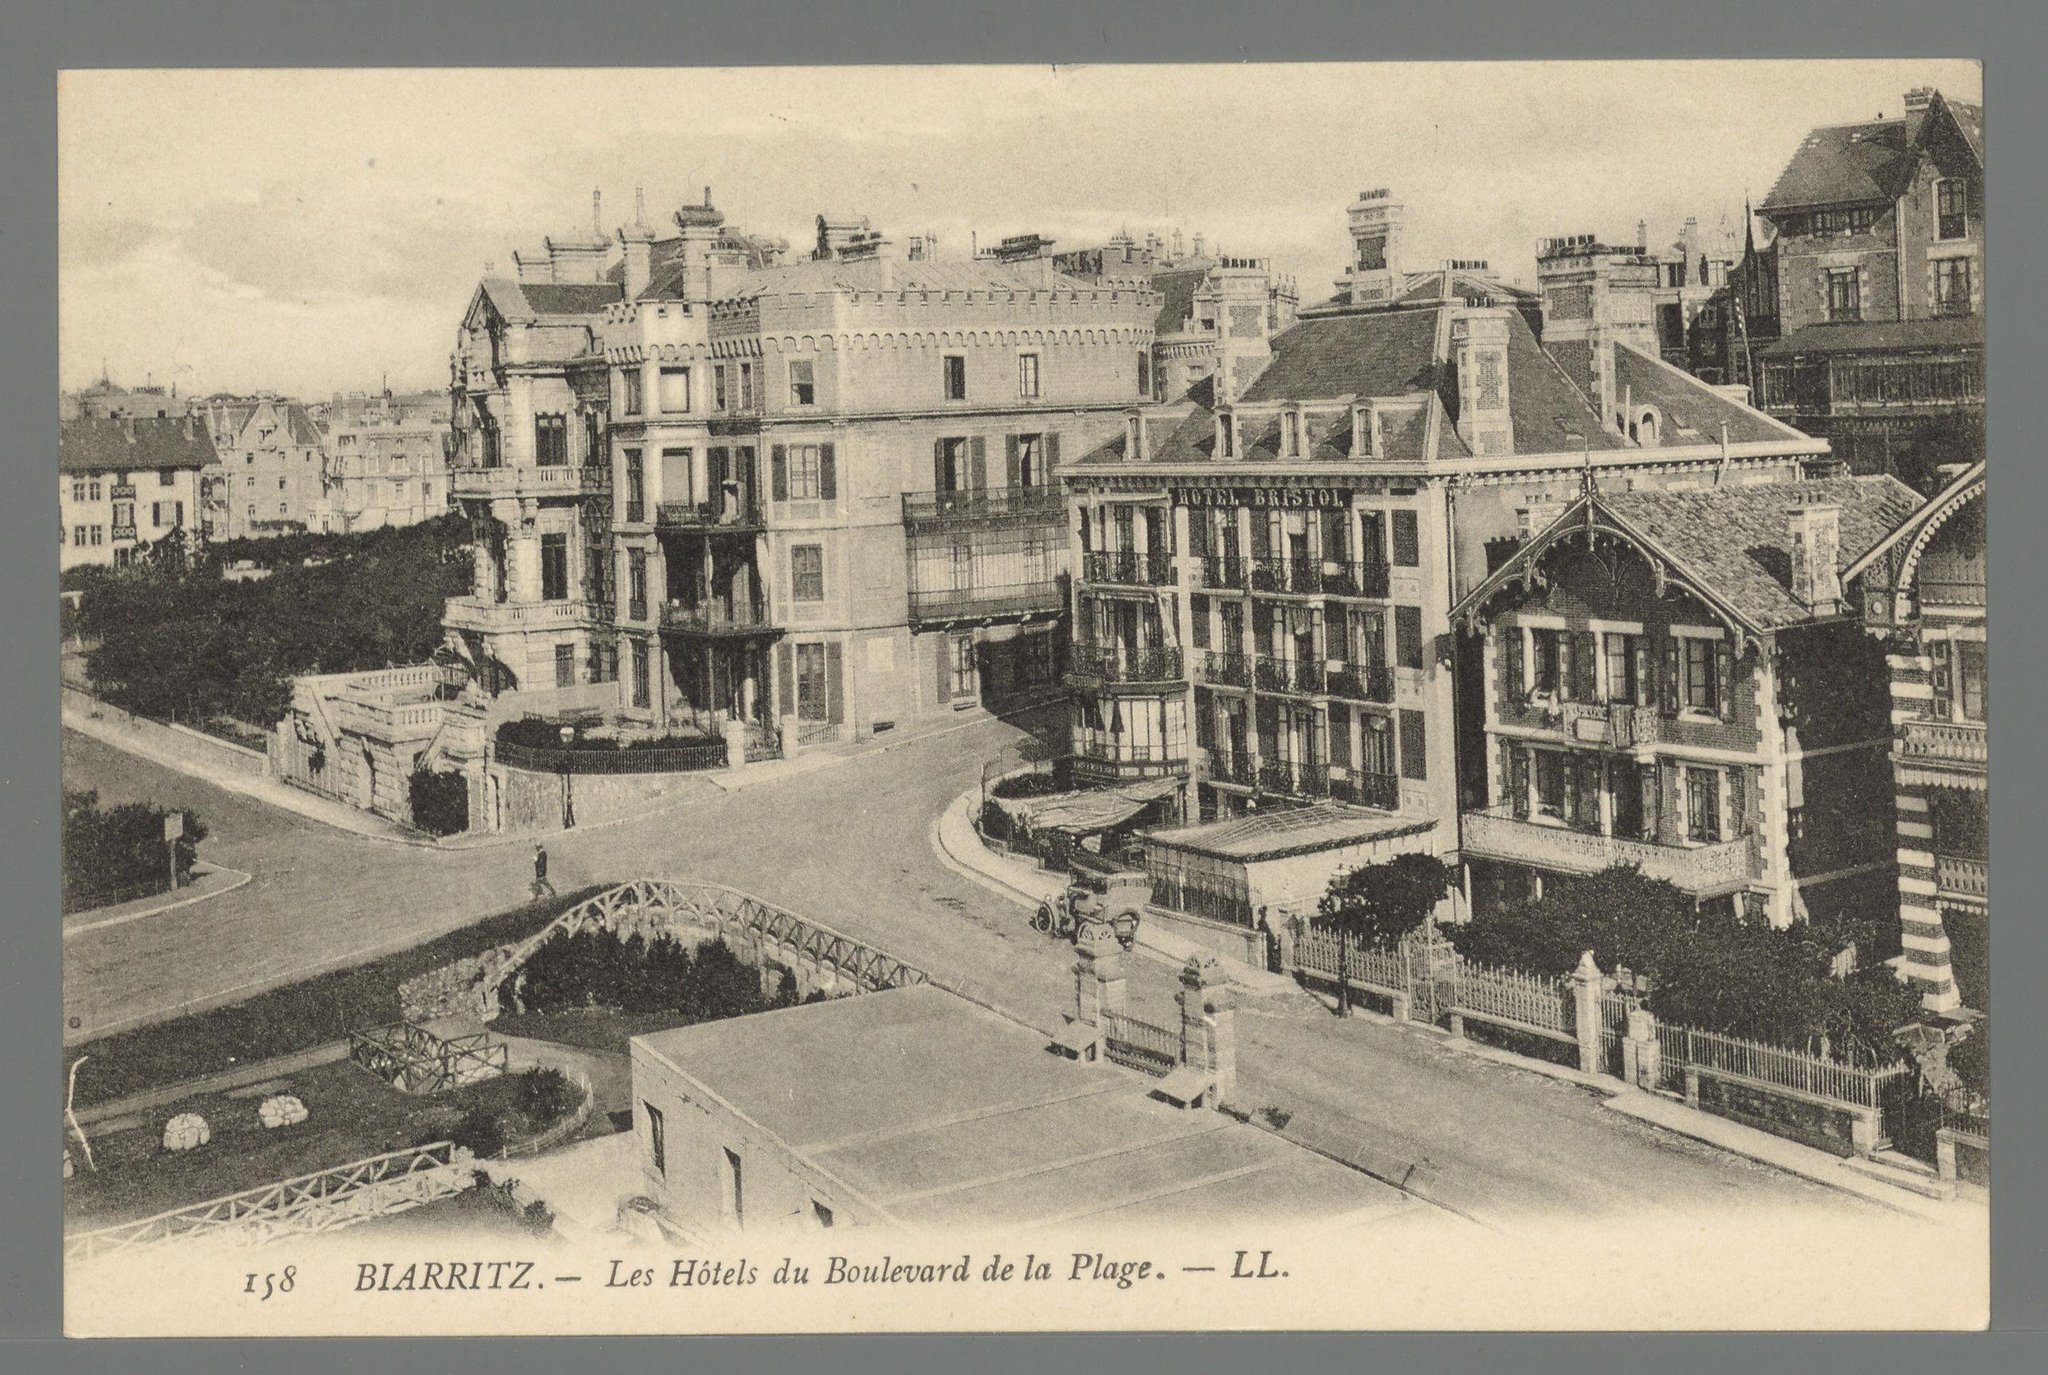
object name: photomechanical print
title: Biarritz. Les Hôtels du Boulevard de la Plage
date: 1903-1920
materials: cardboard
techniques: photograph, writing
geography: biarritz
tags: urban housing, hotel, hostelry, inn